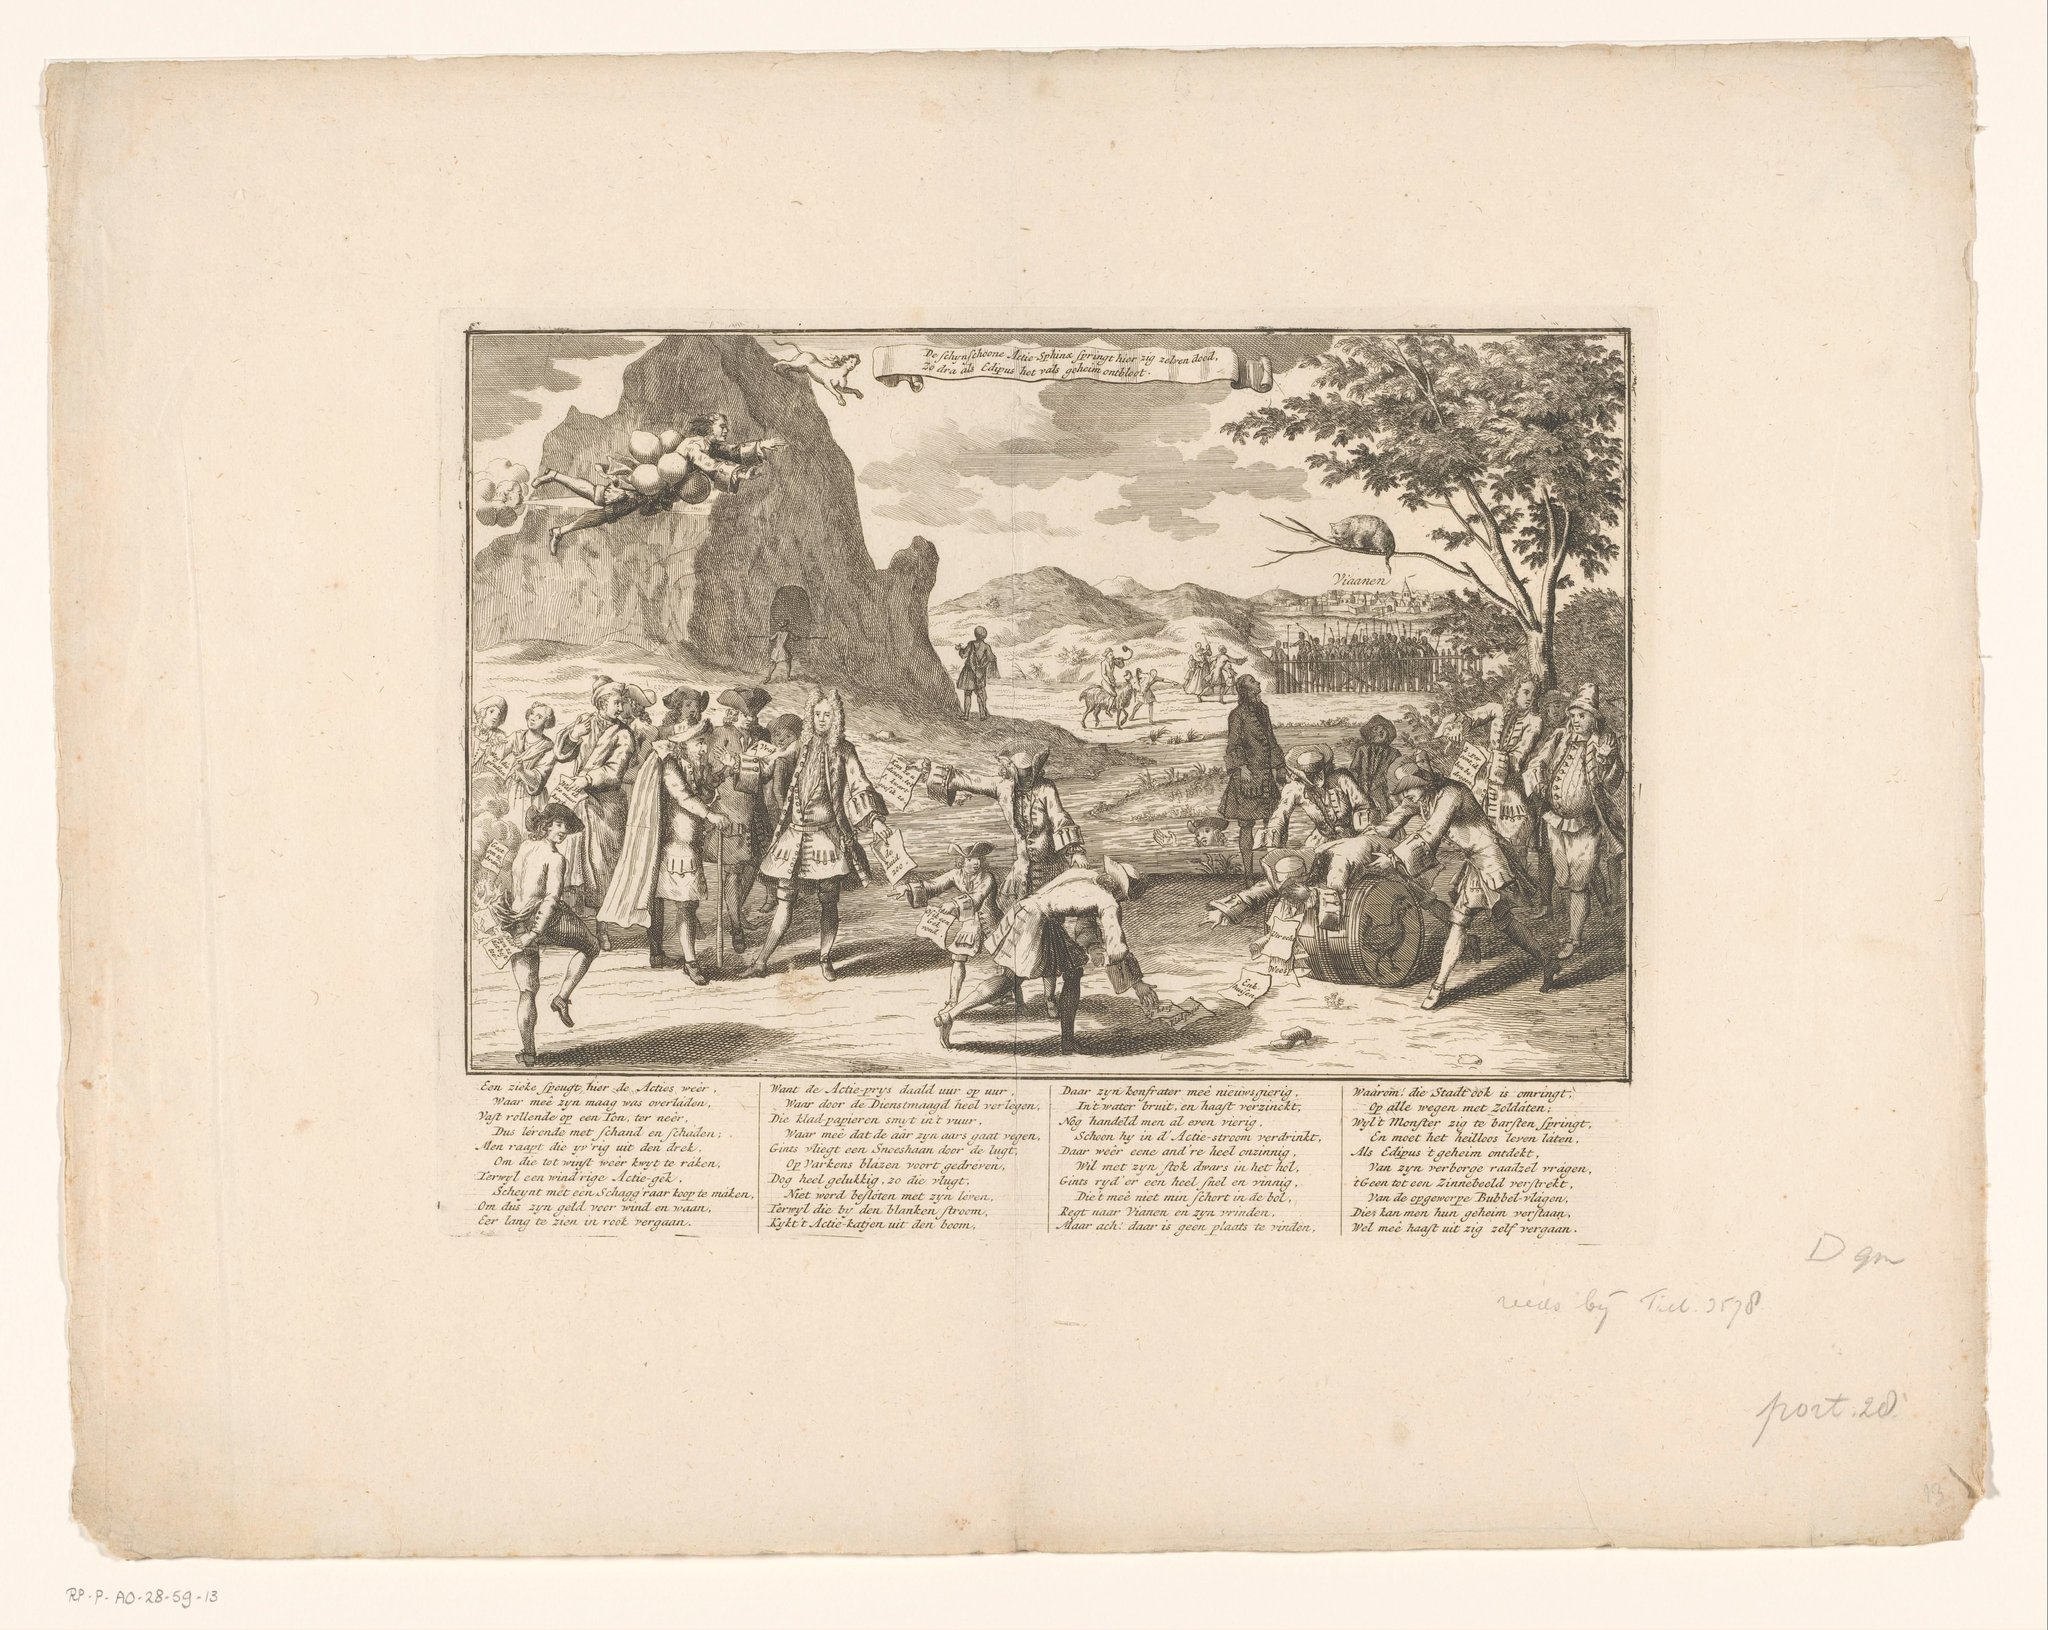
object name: cartoon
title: Het Groote Tafereel der Dwaasheid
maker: Anonymous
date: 1720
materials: paper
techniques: engraving, etching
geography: northern netherlands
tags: financial panic, sphinx (lion/woman); 'sfinge' (ripa)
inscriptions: collector's mark: Lugt 2228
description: Landschap waarin de Actiesfinx van een berg springt, een man met ballonnen door de lucht wordt geblazen en op de voorgrond verschillende groepen bezig zijn met de windhandel. In de verte Vianen. In het onderschrift een vers in vier kolommen. Prent 43 in de serie Het Groote Tafereel der Dwaasheid met spotprenten op de Windhandel of Actiehandel van 1720.